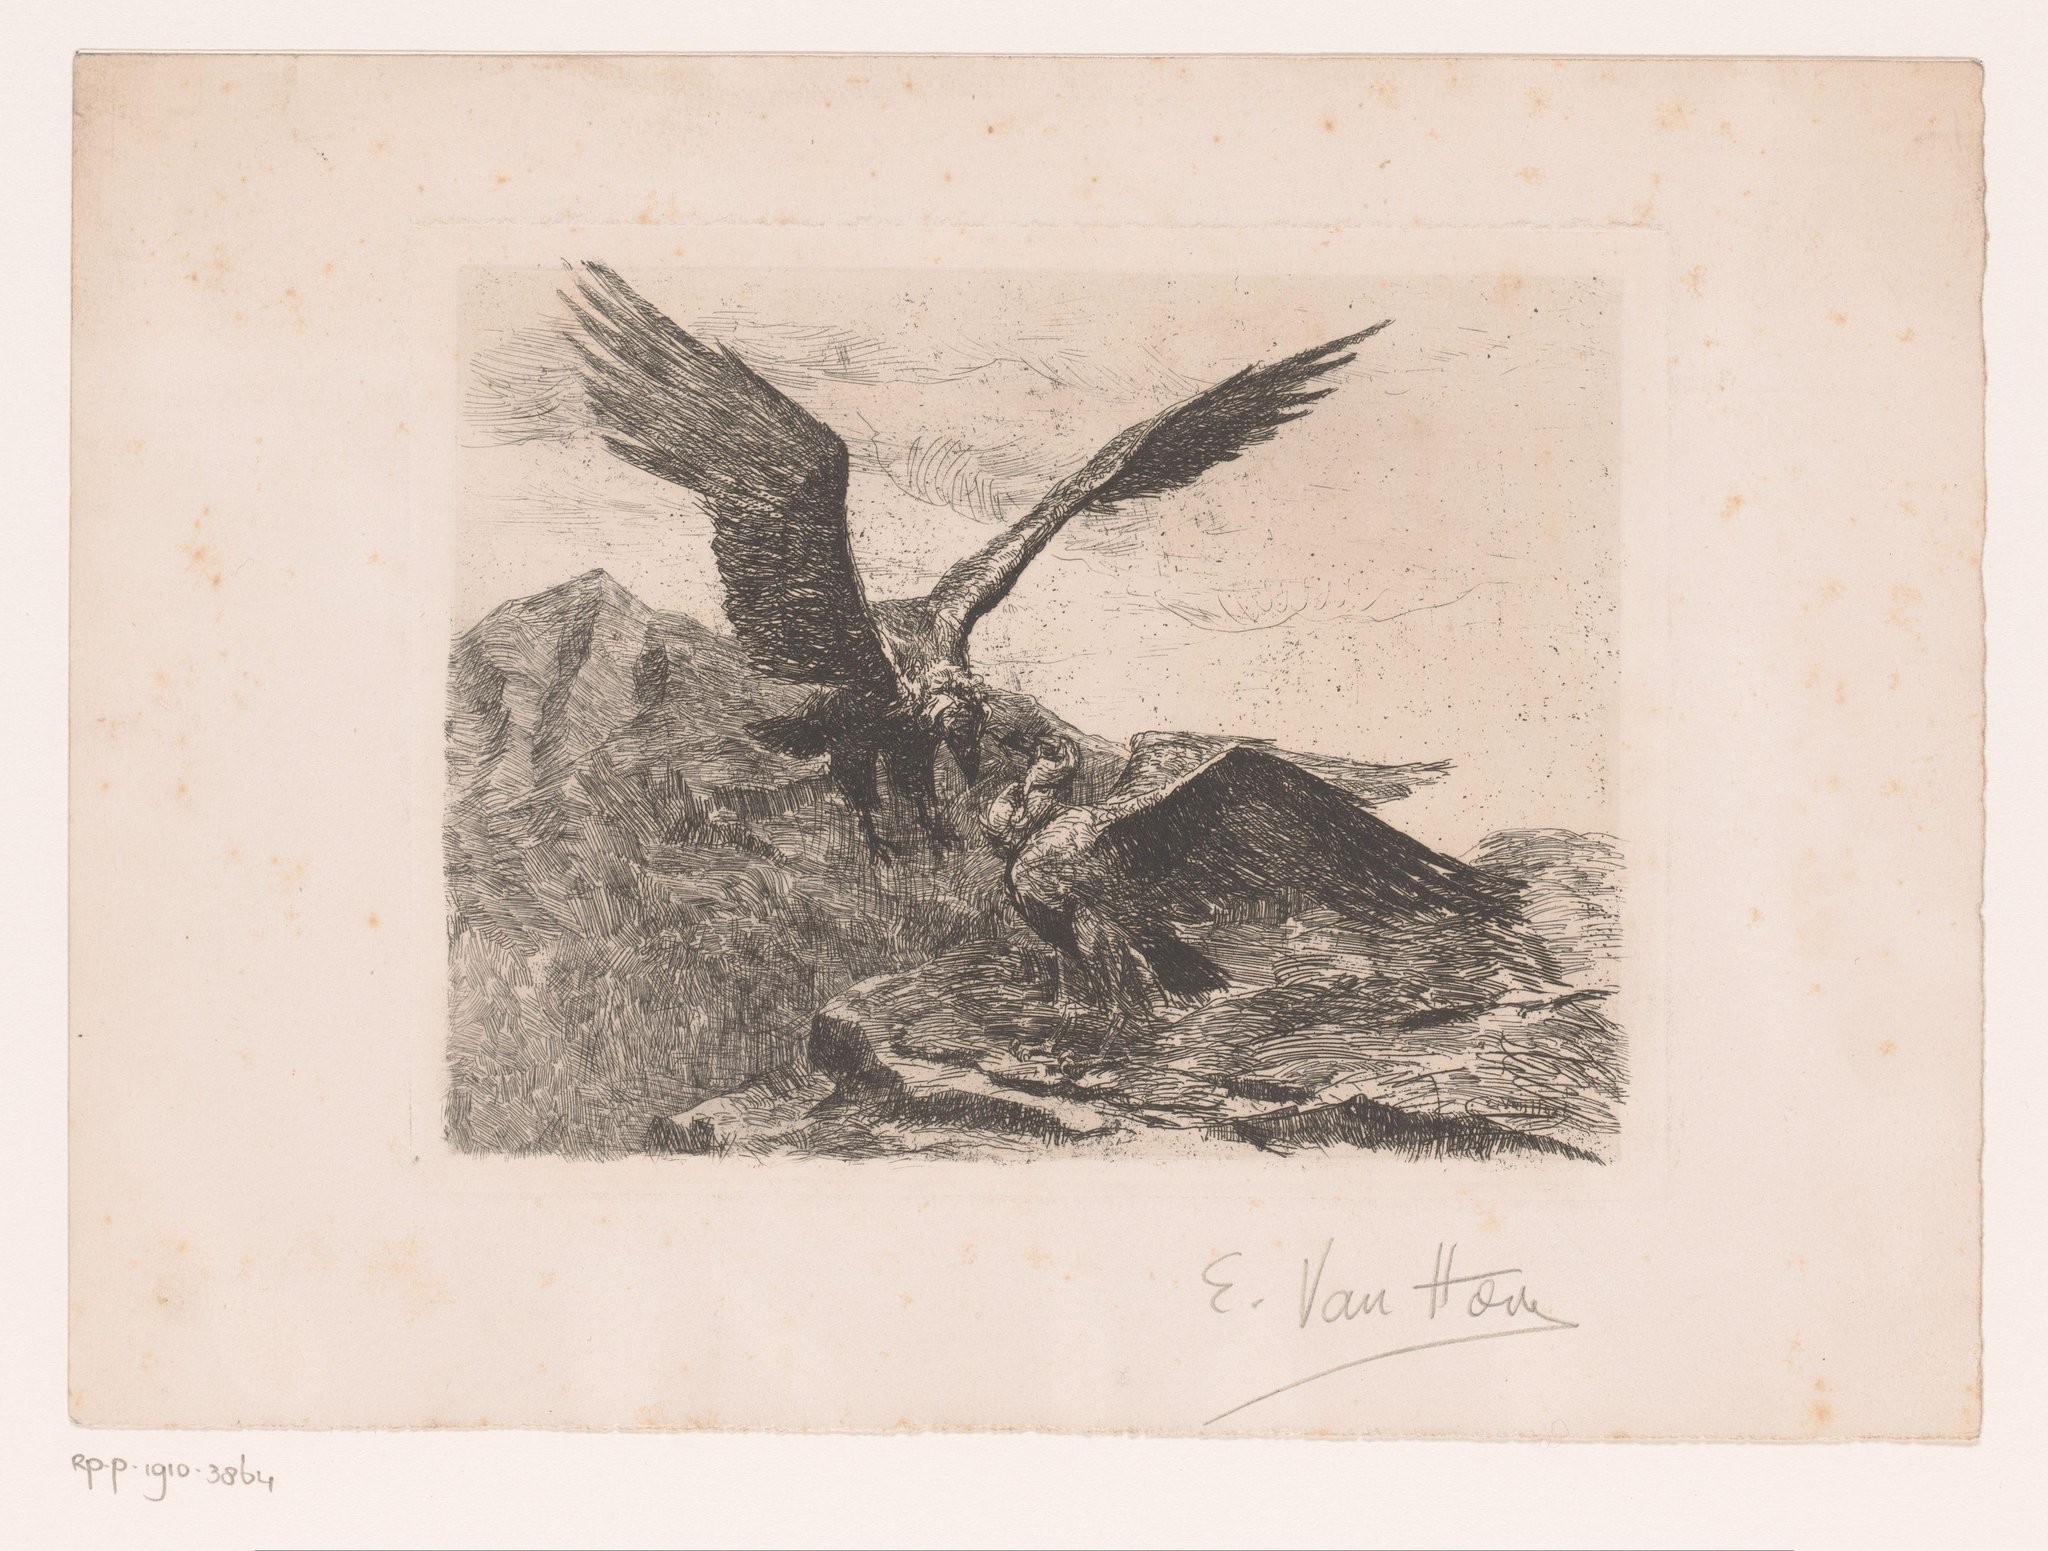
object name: print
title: Twee arenden in een gebergte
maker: eugène van hove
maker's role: print maker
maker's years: 1869-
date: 1879-1910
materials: paper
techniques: etching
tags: predatory birds: eagle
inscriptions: annotation: ‘duel d'ammaud van hove’, collector's mark: Lugt 2228